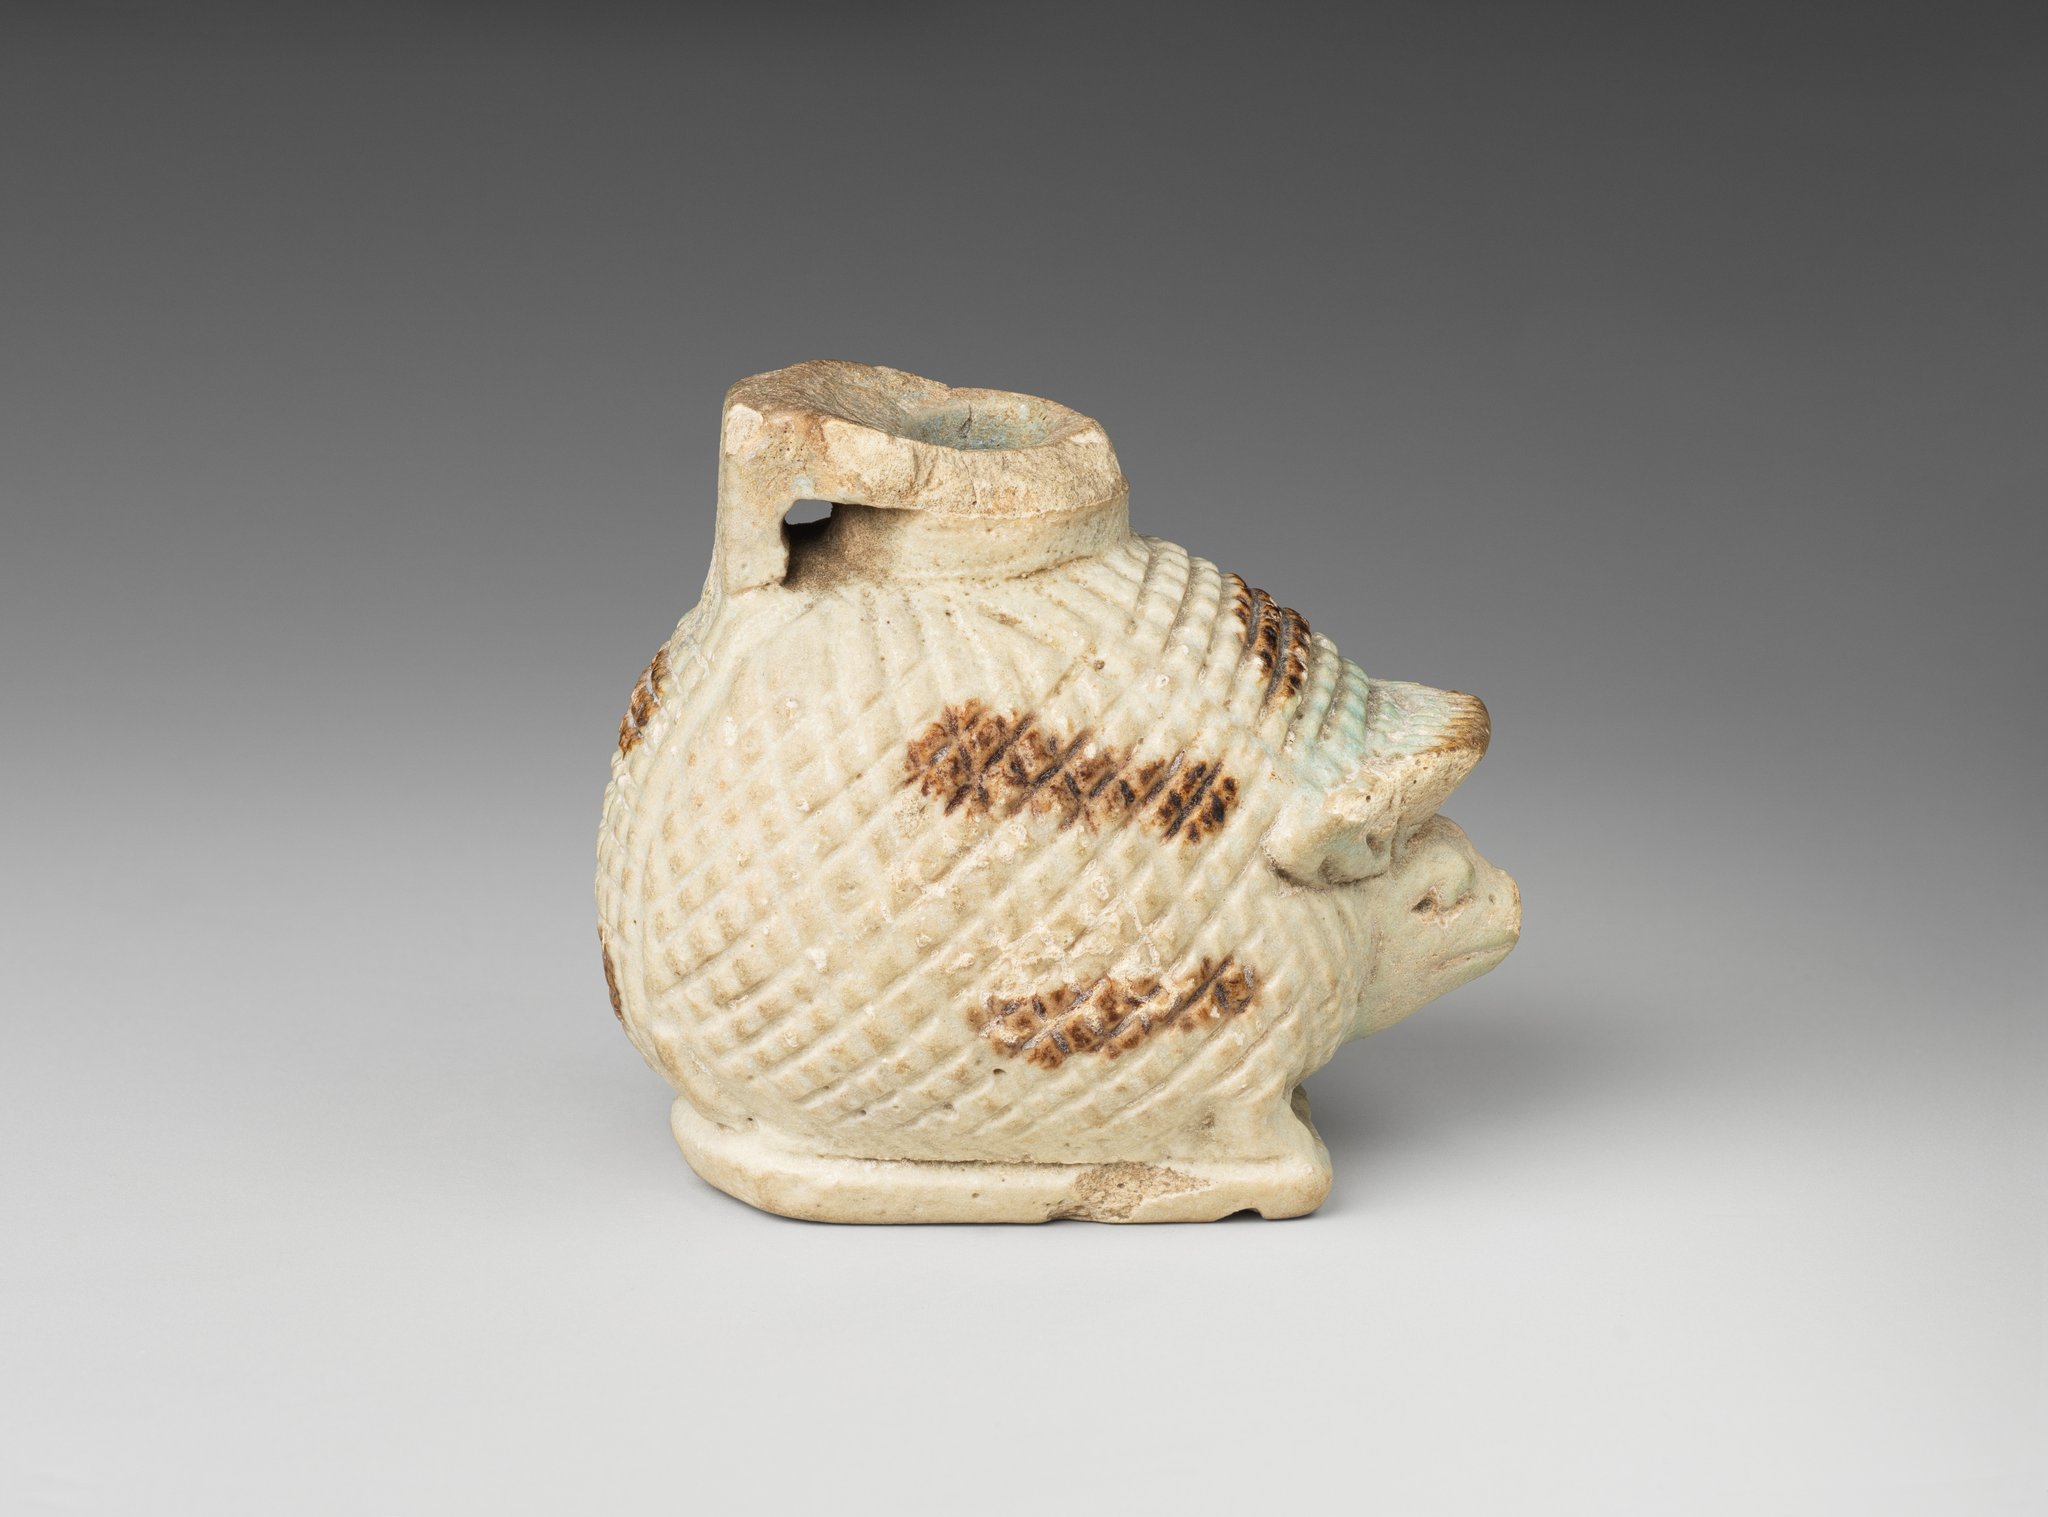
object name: jar, hedgehog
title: Aryballos (perfume jar) in the form of a hedgehog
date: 600-501 BCE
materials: faience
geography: egypt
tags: hedgehogs